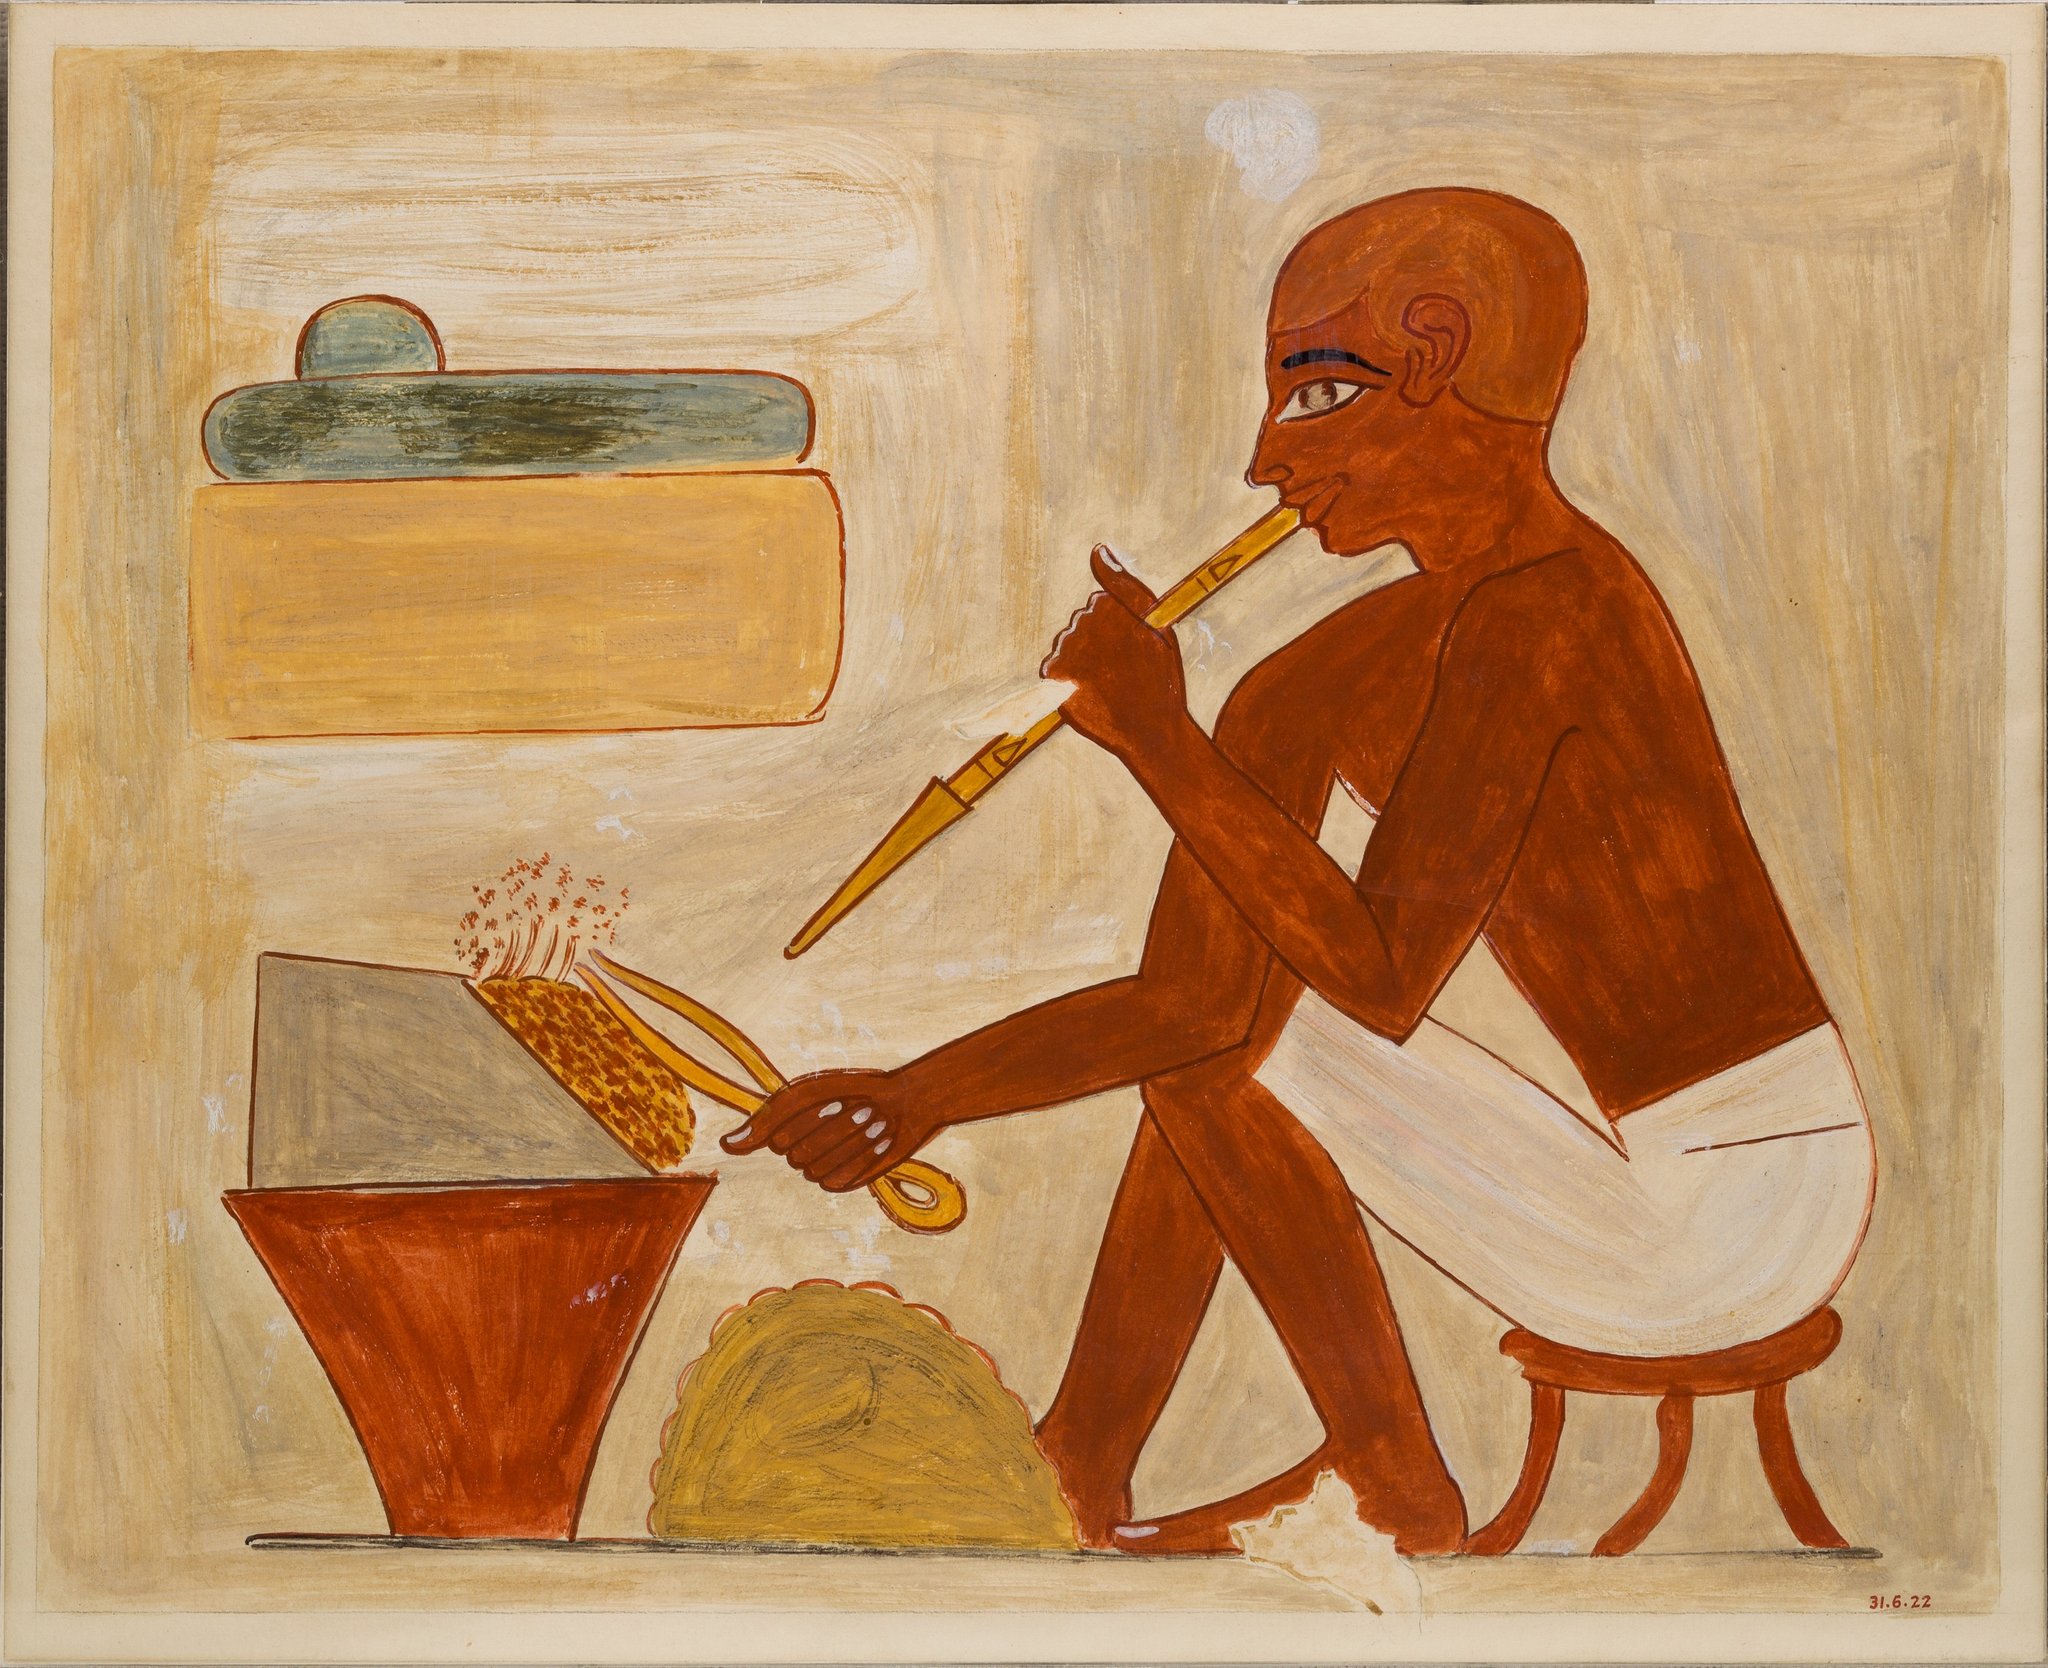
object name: facsimile, metal work, bellow, rekhmire tt 100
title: Metal Working, Tomb of Rekhmire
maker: nina de garis davies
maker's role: artist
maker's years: 1881-1965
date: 1504-1425 BCE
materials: ink, paint, paper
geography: egypt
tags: men,working,rekhmire-exhibition